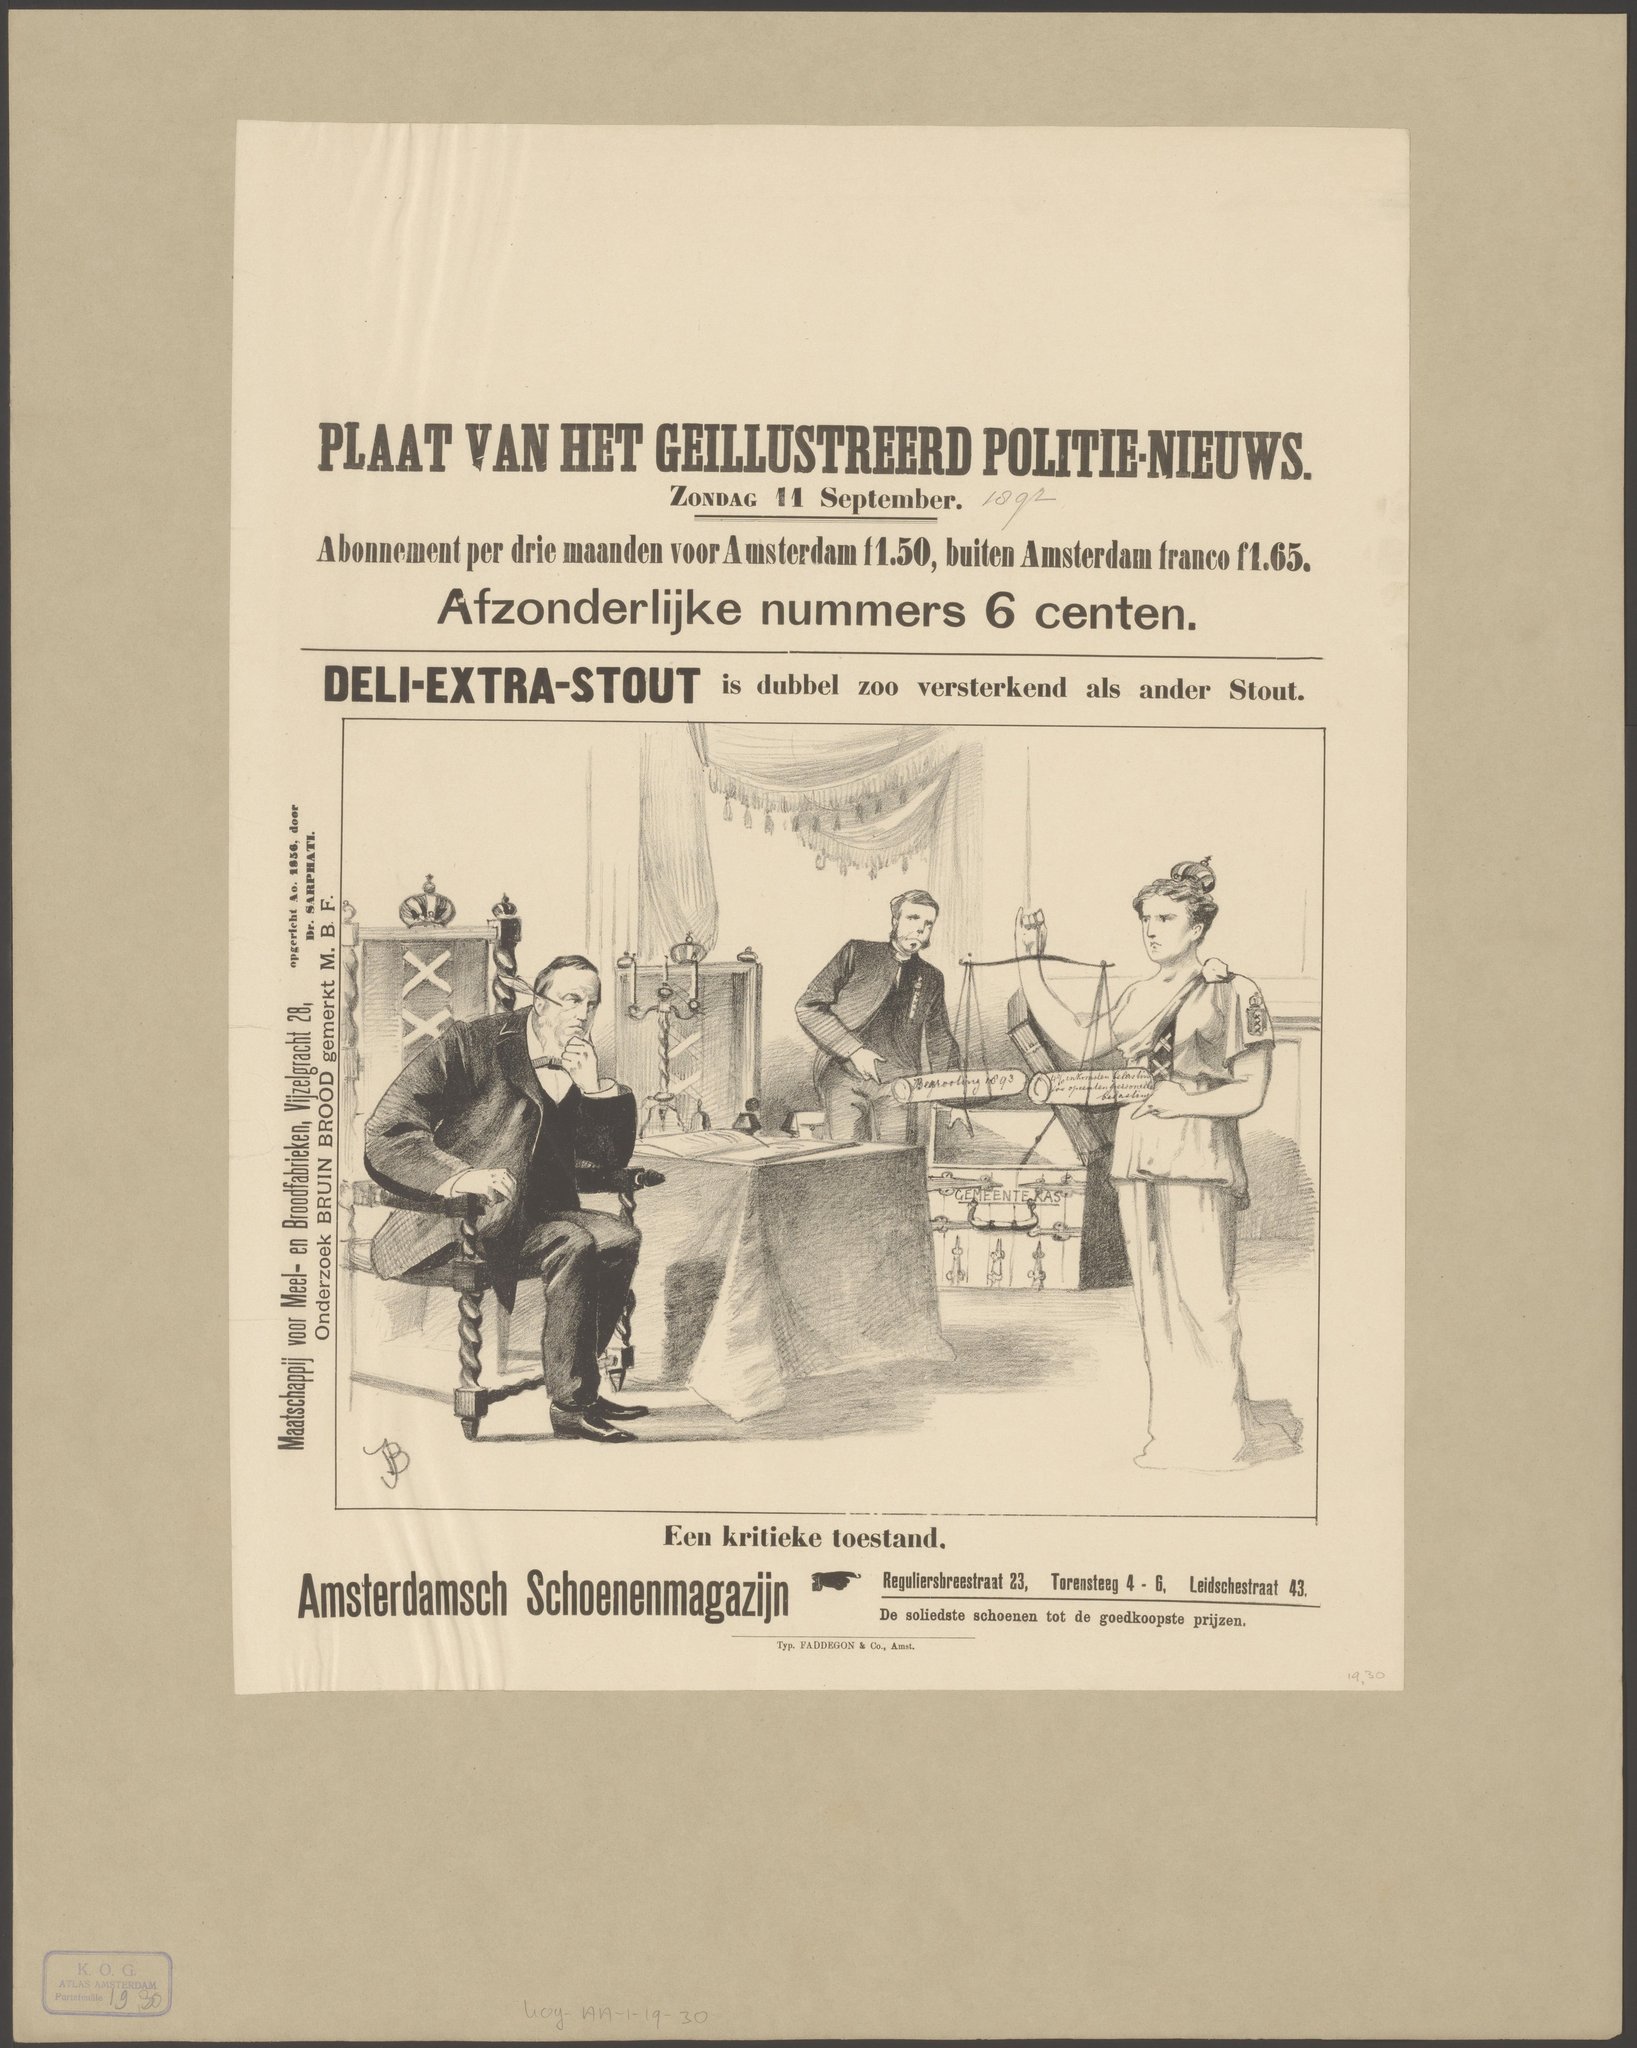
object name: cartoon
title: Een kritieke toestand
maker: johan braakensiek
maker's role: draughtsman, print maker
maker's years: 1858-1940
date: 1892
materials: paper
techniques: letterpress printing, lithograph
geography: amsterdam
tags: politician, personification of a city, town-patron(ess), mayor, burgomaster, political caricatures and satires, amsterdam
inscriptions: collector's mark: ‘19,30’ Lugt 1641b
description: Onderwerpsrubriek binnen de Atlas Amsterdam: Herinneringen aan regeringsleden en hunne huisgezinnen [na 1800].